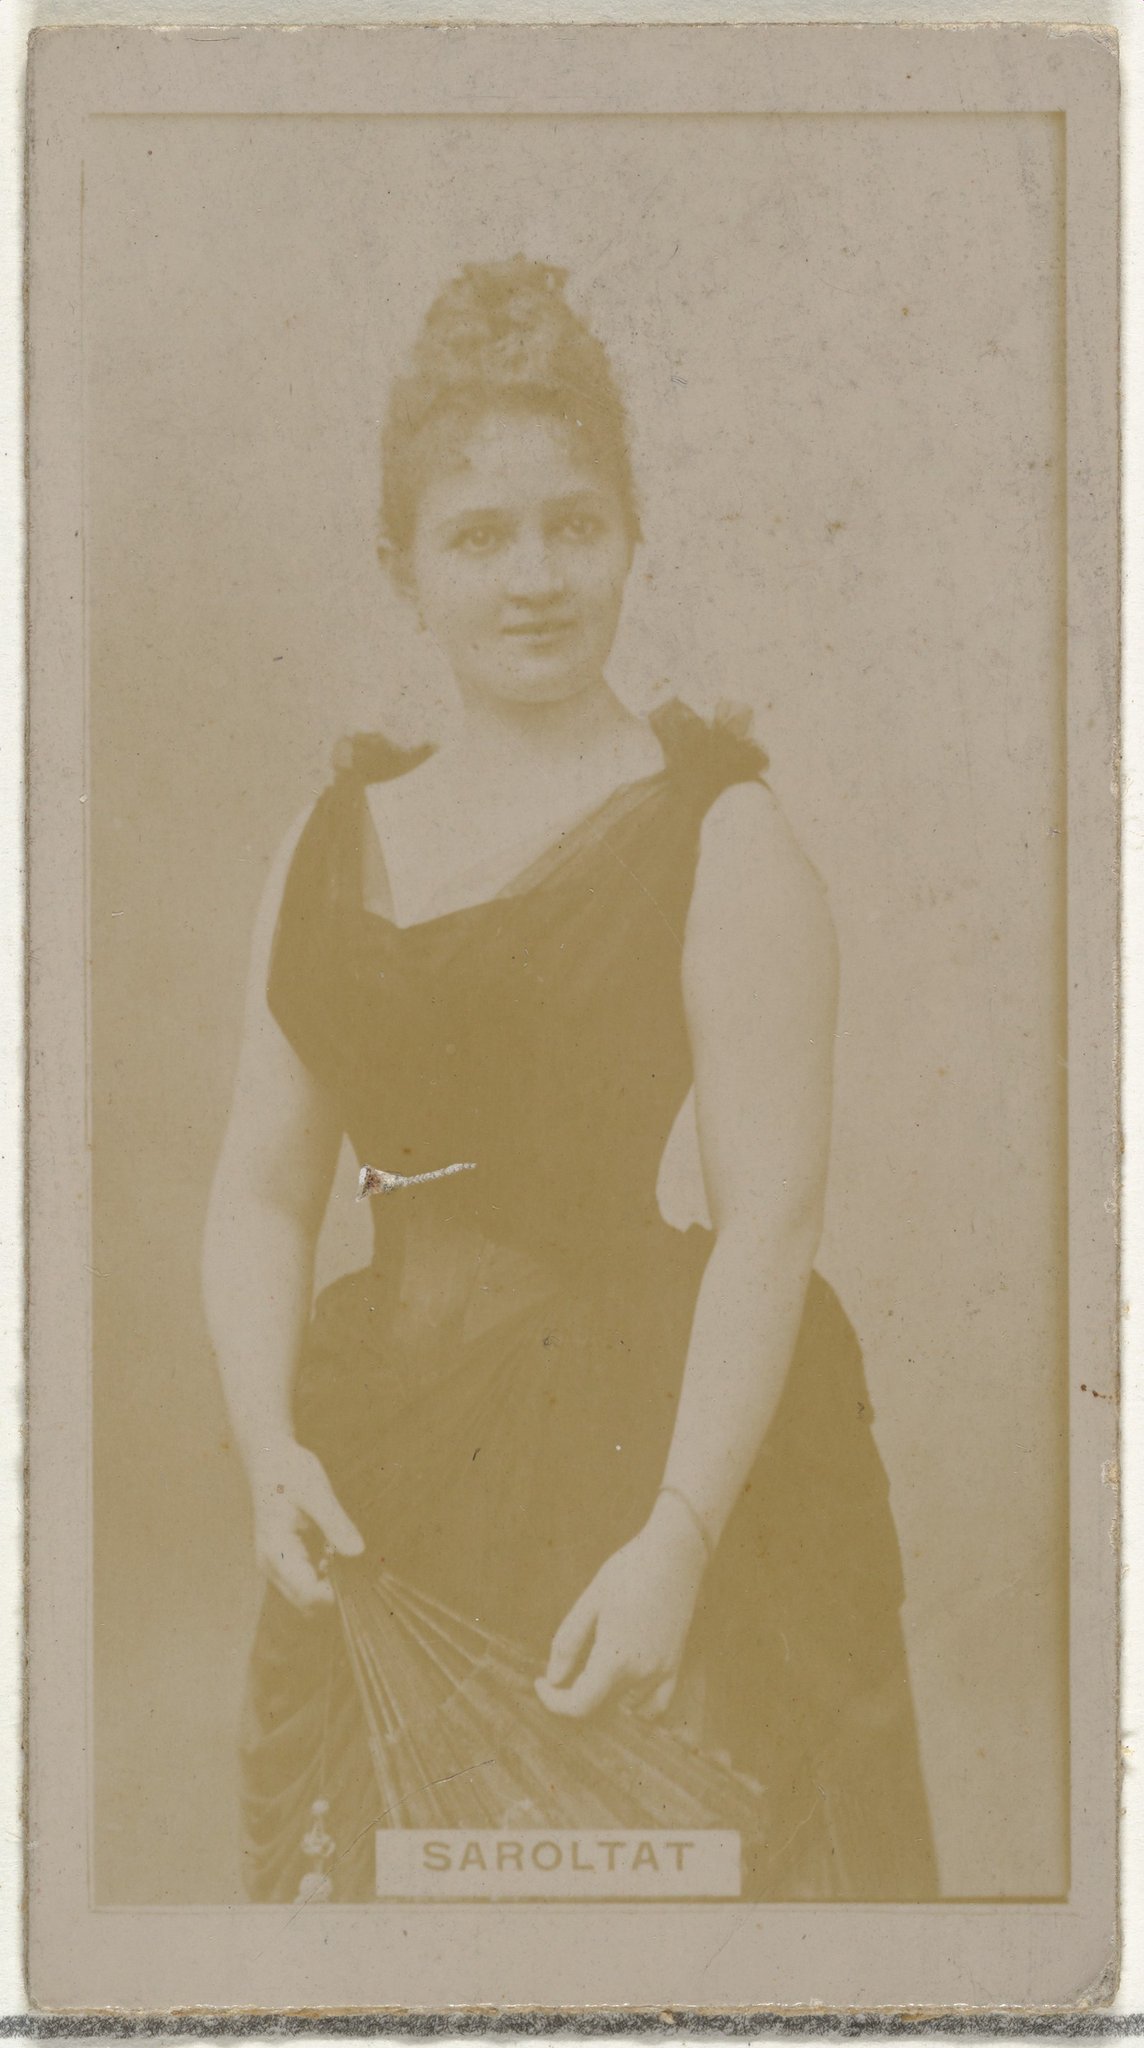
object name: photograph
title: Saroltat, from the Actors and Actresses series (N145-8) issued by Duke Sons & Co. to promote Duke Cigarettes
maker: w. duke, sons & co.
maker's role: publisher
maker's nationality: american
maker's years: 1870-1920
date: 1891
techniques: albumen silver print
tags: portraits,women,actresses